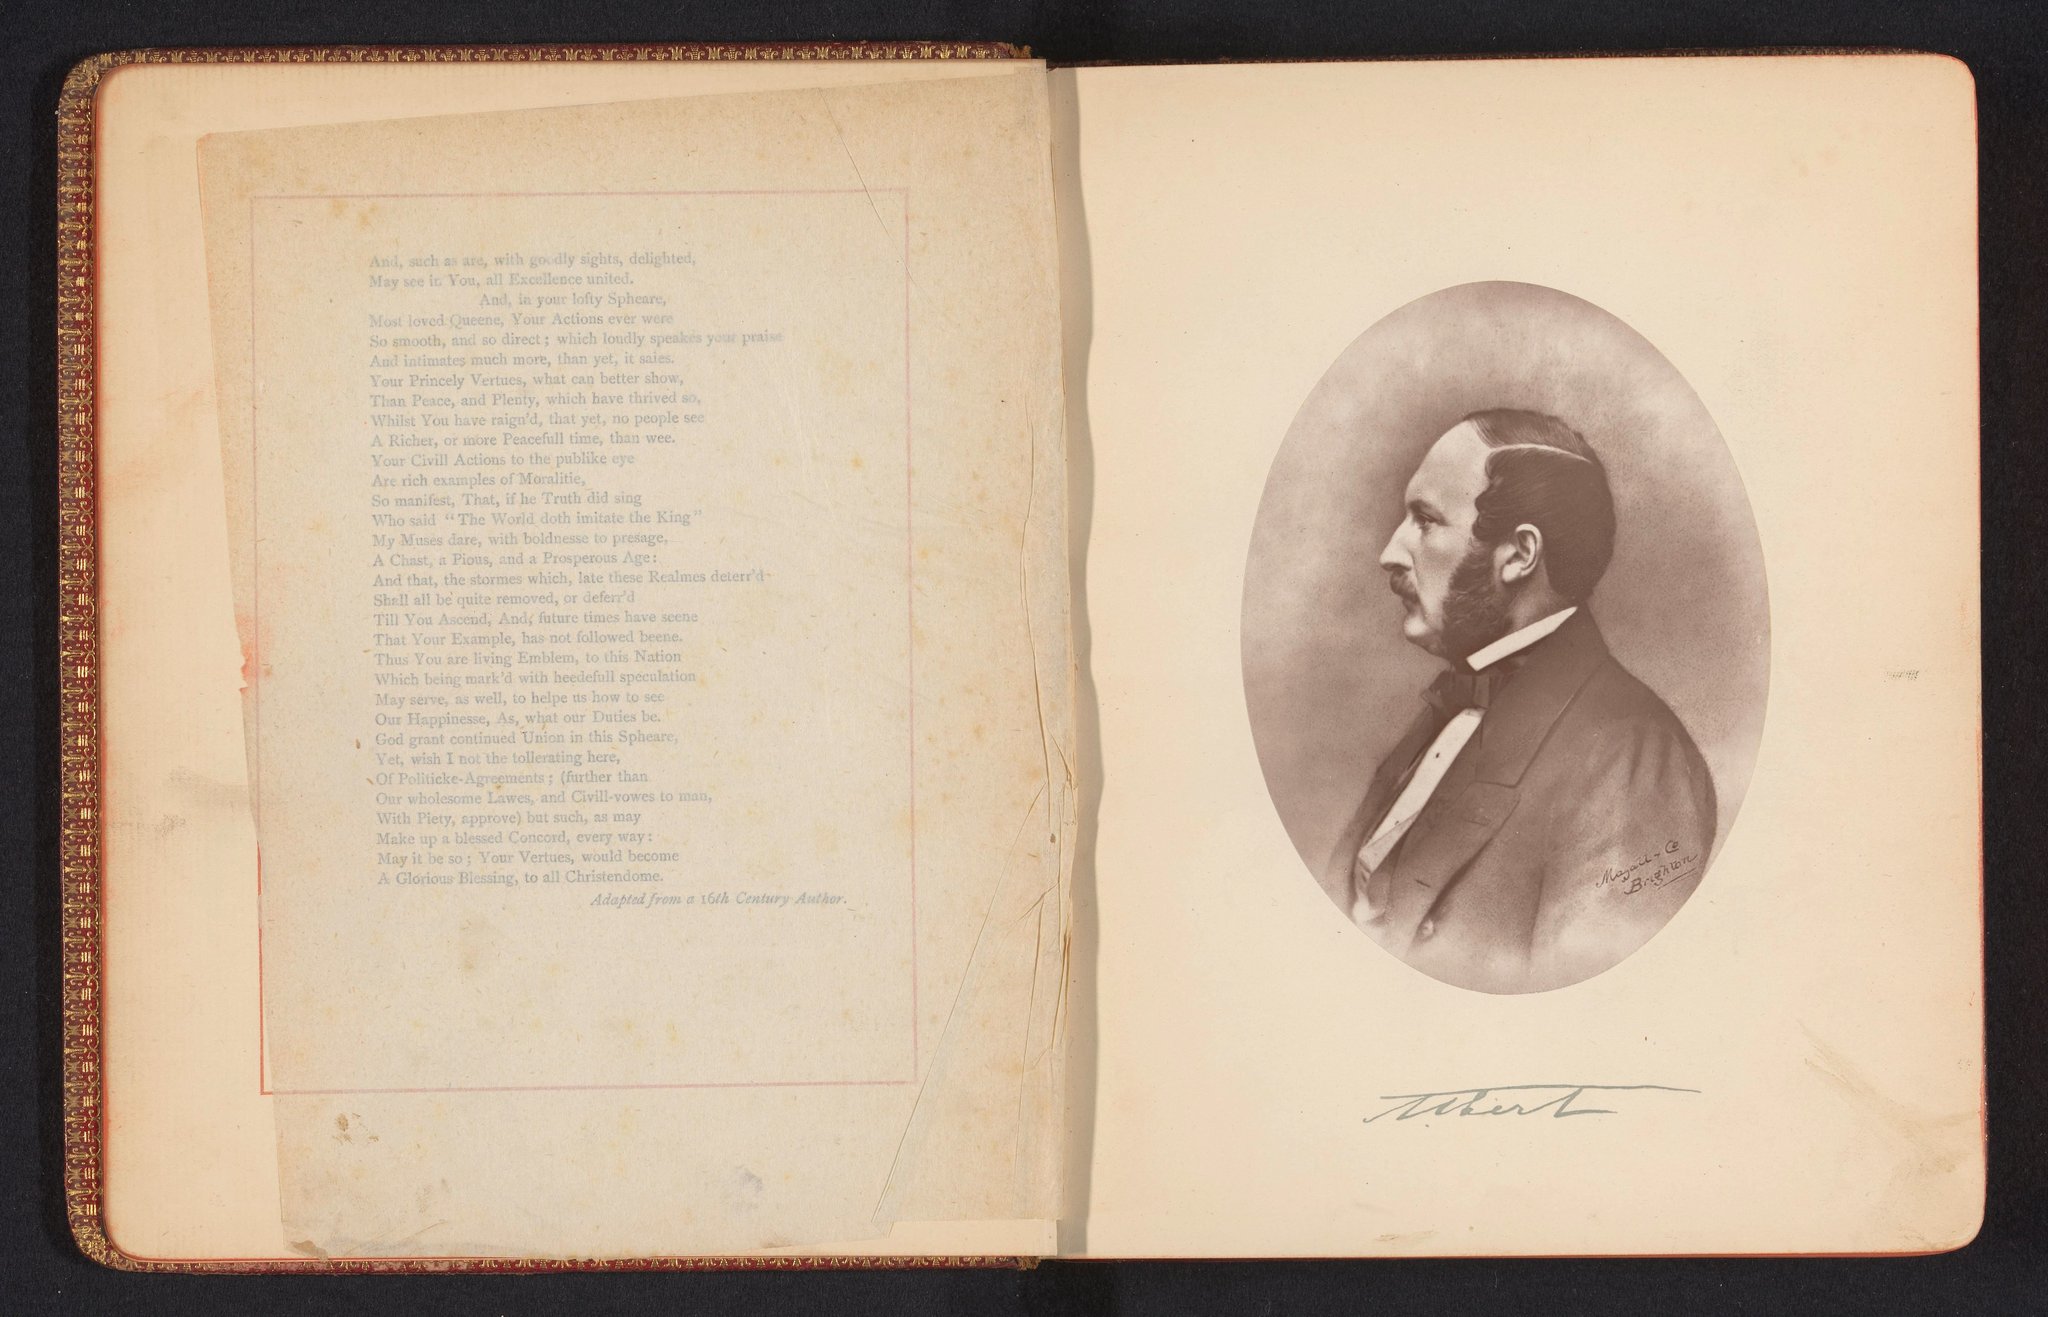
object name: page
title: Portret van Albert van Saksen-Coburg en Gotha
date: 1877-1887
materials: paper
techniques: woodburytype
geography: brighton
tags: albert (prins van saksen-coburg en gotha), adult man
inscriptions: name